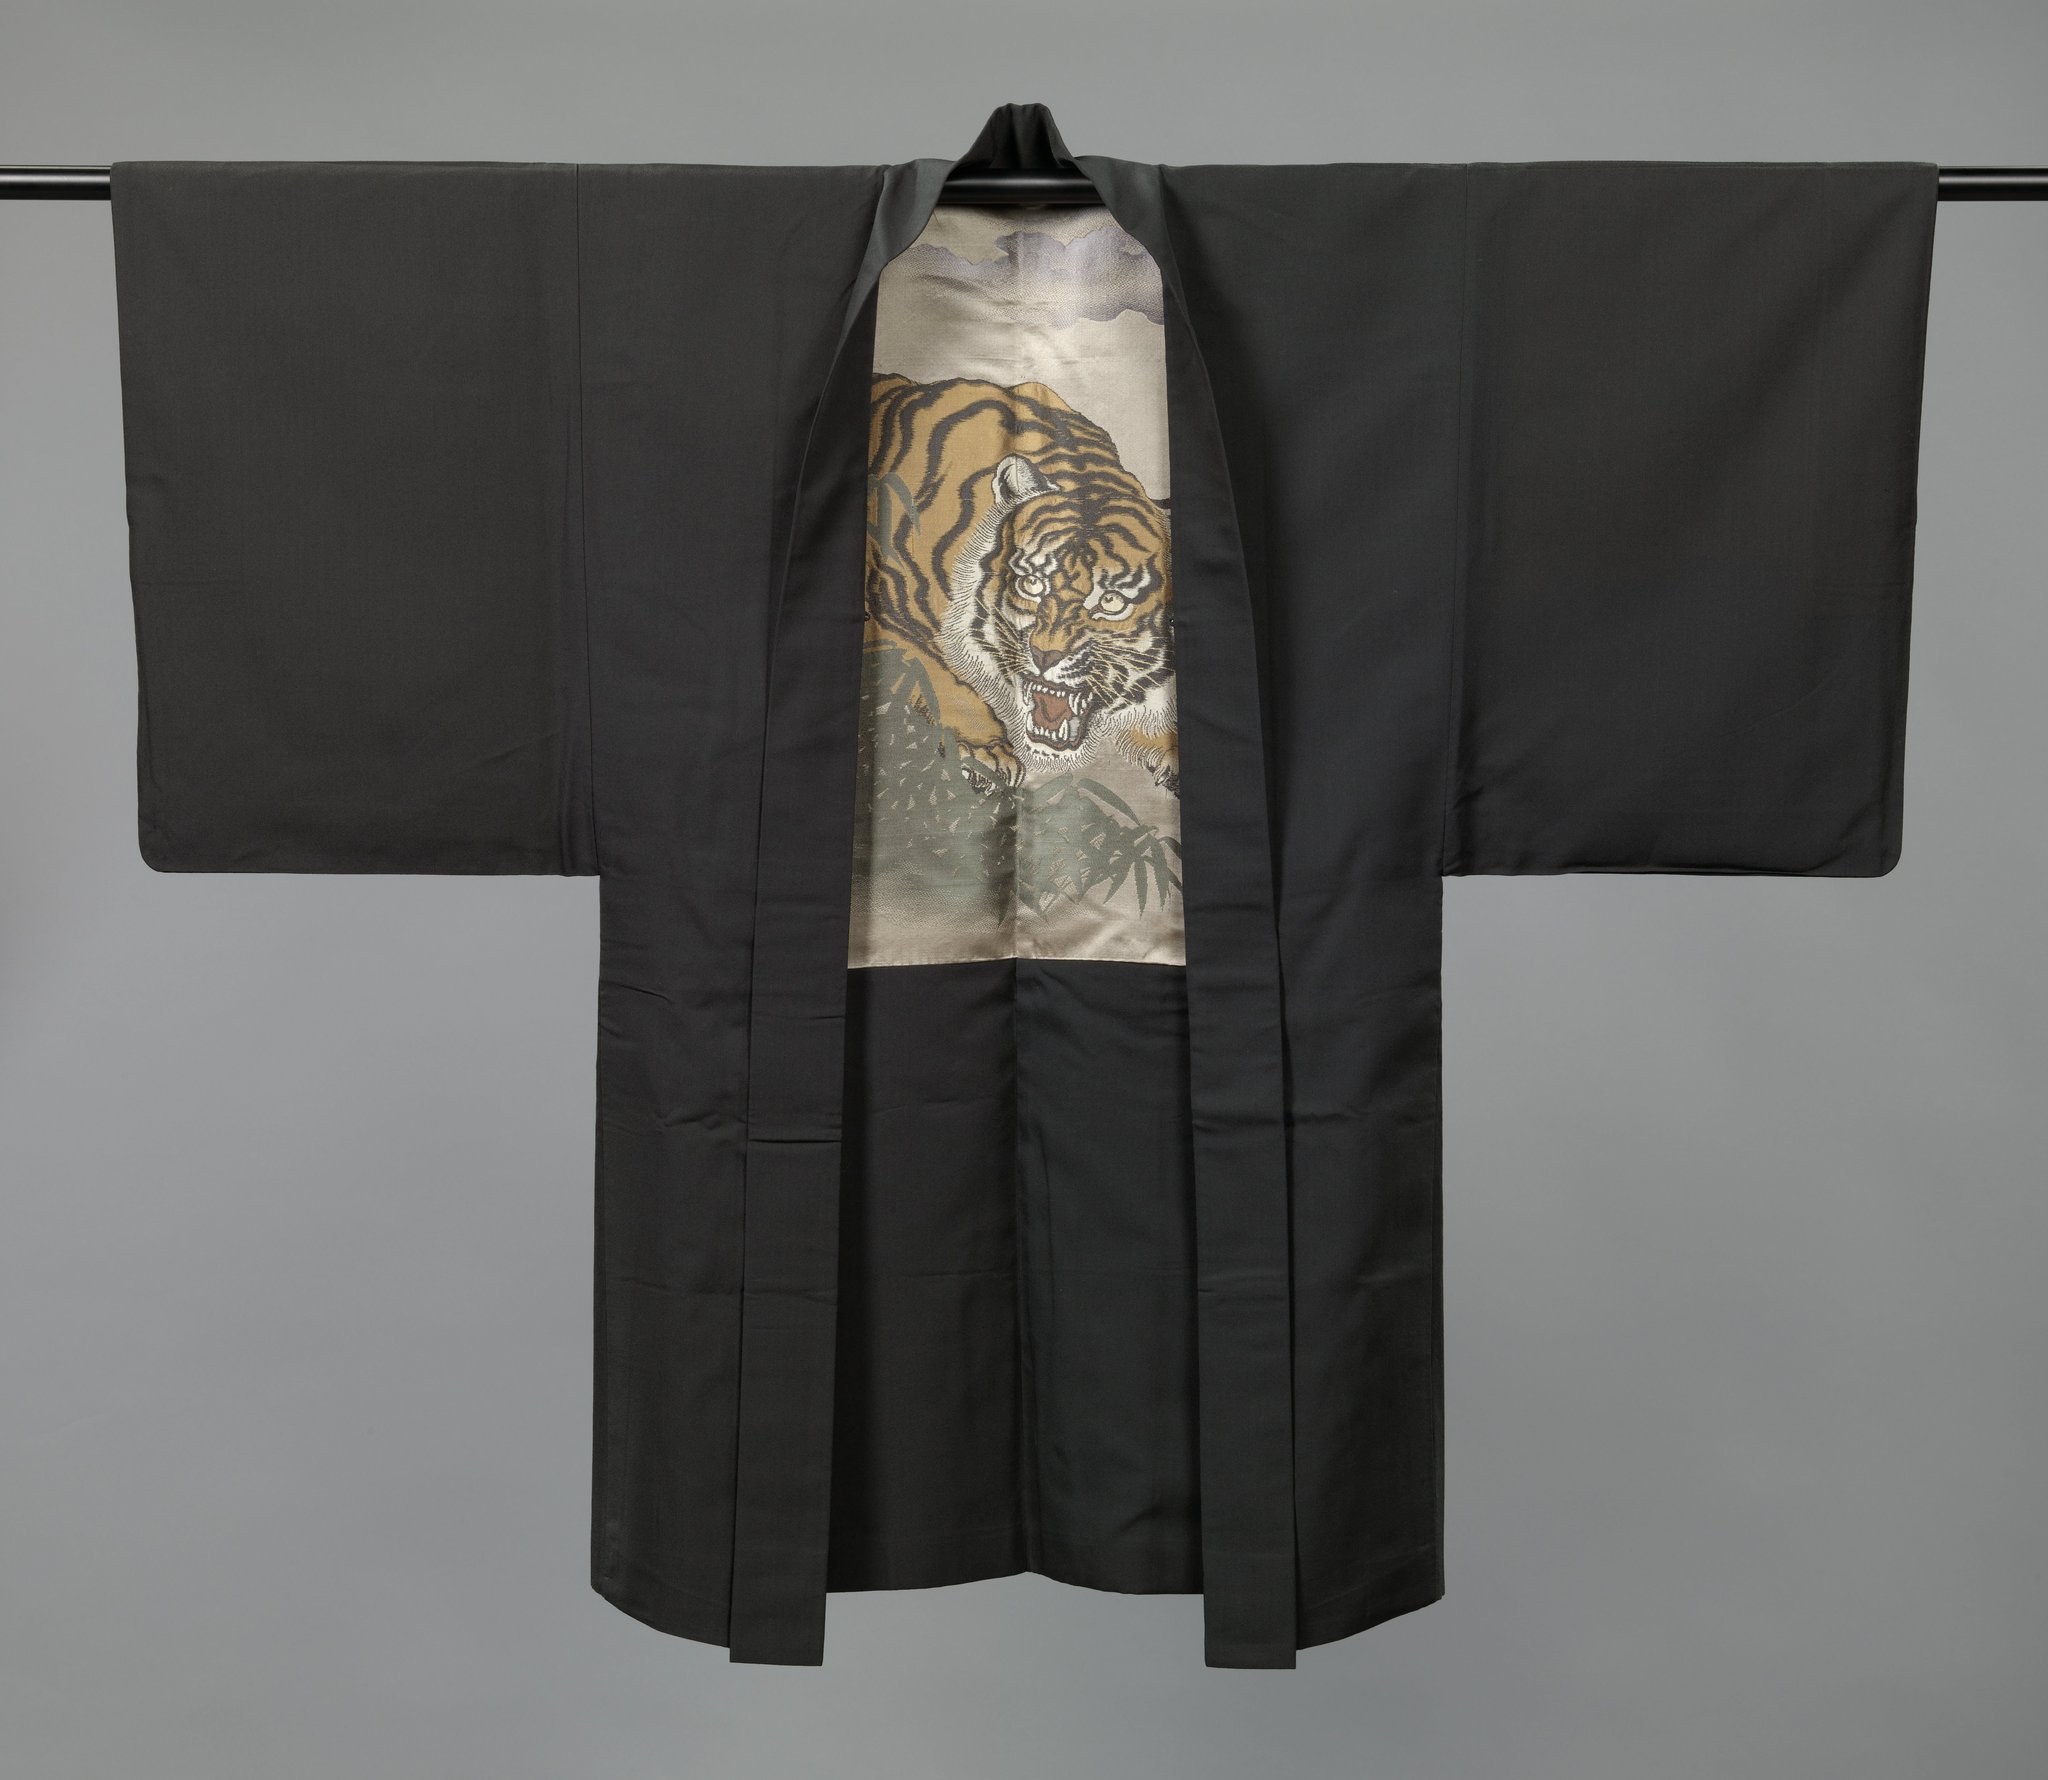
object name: kimono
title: Man’s jacket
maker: Anonymous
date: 1920-1940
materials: silk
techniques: weave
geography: japan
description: The outside of a formal man’s jacket was always black, but the inside could be embellished as one wished. The owner of this jacket chose a classic Japanese motif: a tiger near bamboo. Hidden behind the front panel is a crescent moon. The nocturnal light suggested by the background’s silvery sheen turns the bamboo leaves a dark green.